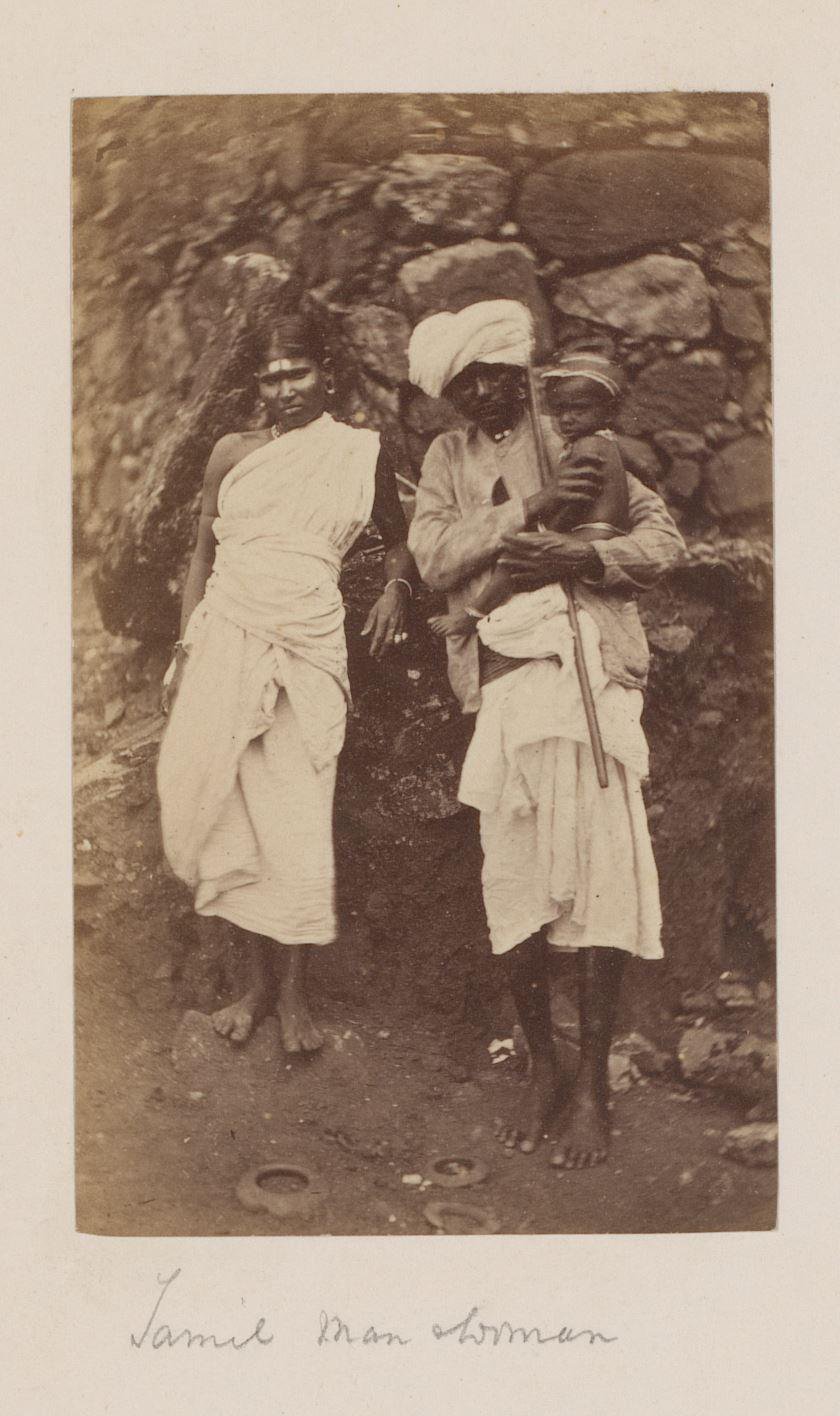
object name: album leaf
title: Tamil man with a child and wife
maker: Anonymous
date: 1880-1900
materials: cardboard, paper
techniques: albumen print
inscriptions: caption: ‘Tamil man woman’, number: ‘1596’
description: Tamil man met kind op de arm en vrouw naast hem, poserend voor een muur. Object zit samen met de andere foto's met nummer RP-F-00-6678 op één blad geplakt.